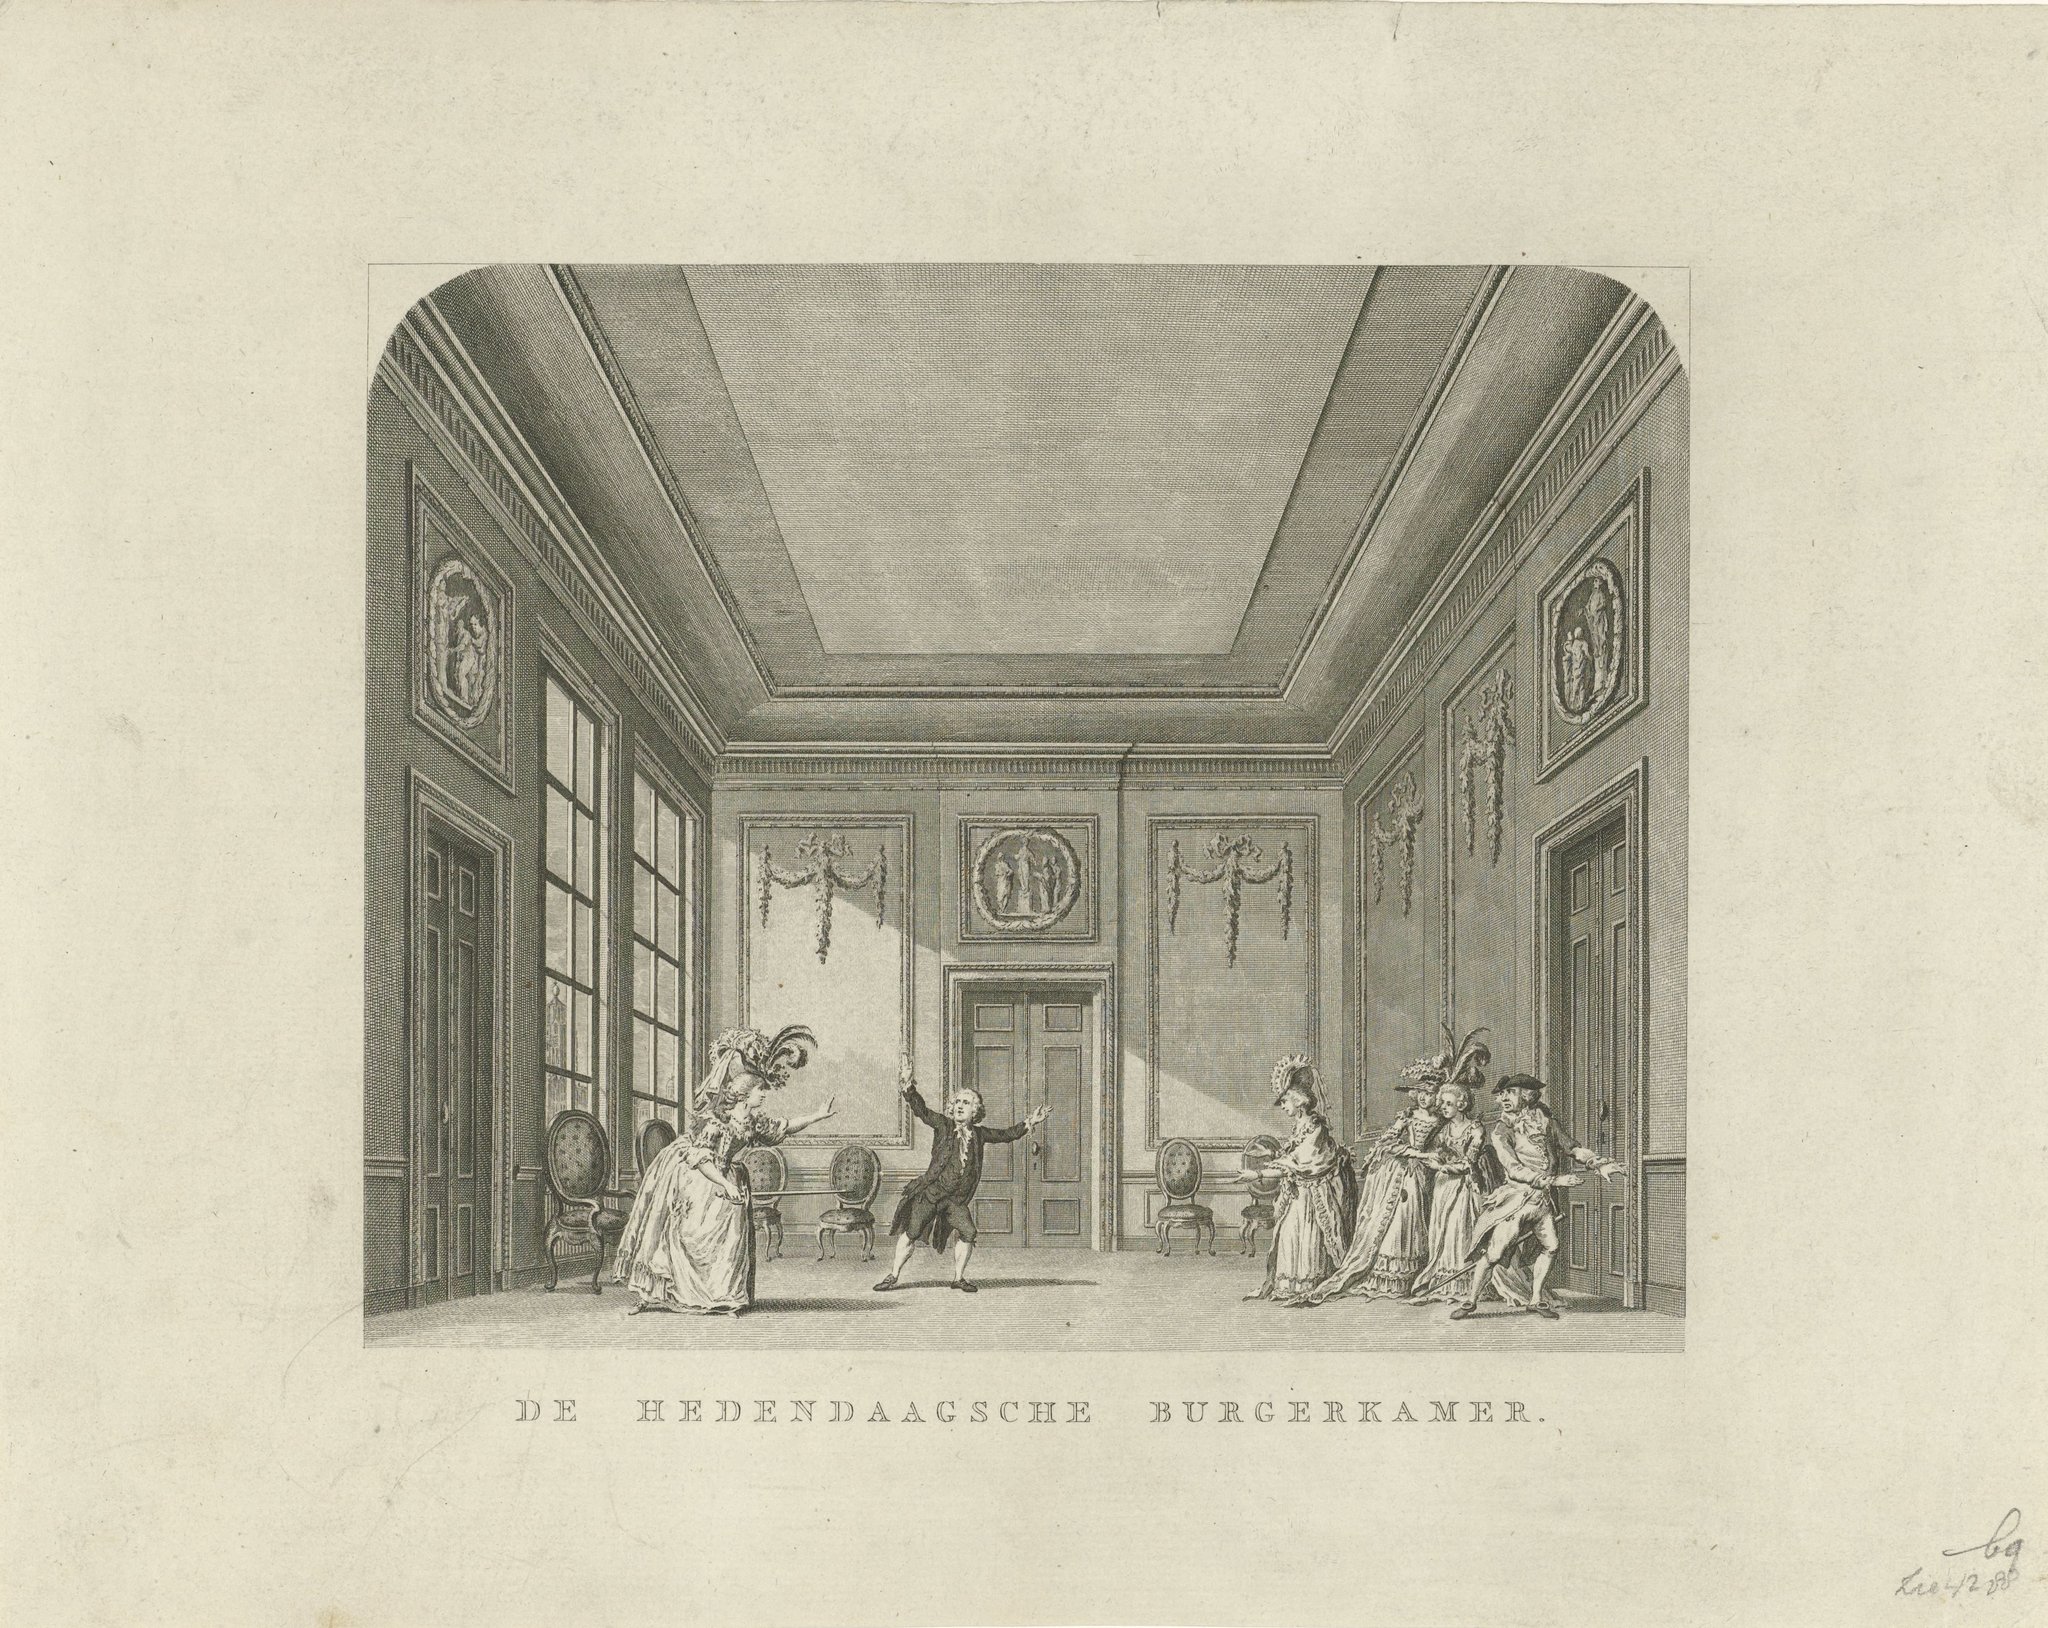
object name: print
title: Toneeldecor: De Hedendaagsche Bugerkamer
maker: cornelis brouwer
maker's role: print maker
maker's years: 1731-1803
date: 1794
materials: paper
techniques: engraving, etching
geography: northern netherlands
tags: stage design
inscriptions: collector's mark: Lugt 2228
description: Het coulissendecor De Hedendaagsche Bugerkamer, met scène uit De Gewaande Onnozele Juffer, of De Belagchelijke Poeët. Aparte afdruk van alleen het decor, zonder de passe-partout met het toneel en de zaal. Behorend bij de serie van veertien toneeldecors van de nieuwe Amsterdamse Schouwburg, 1787-1794.